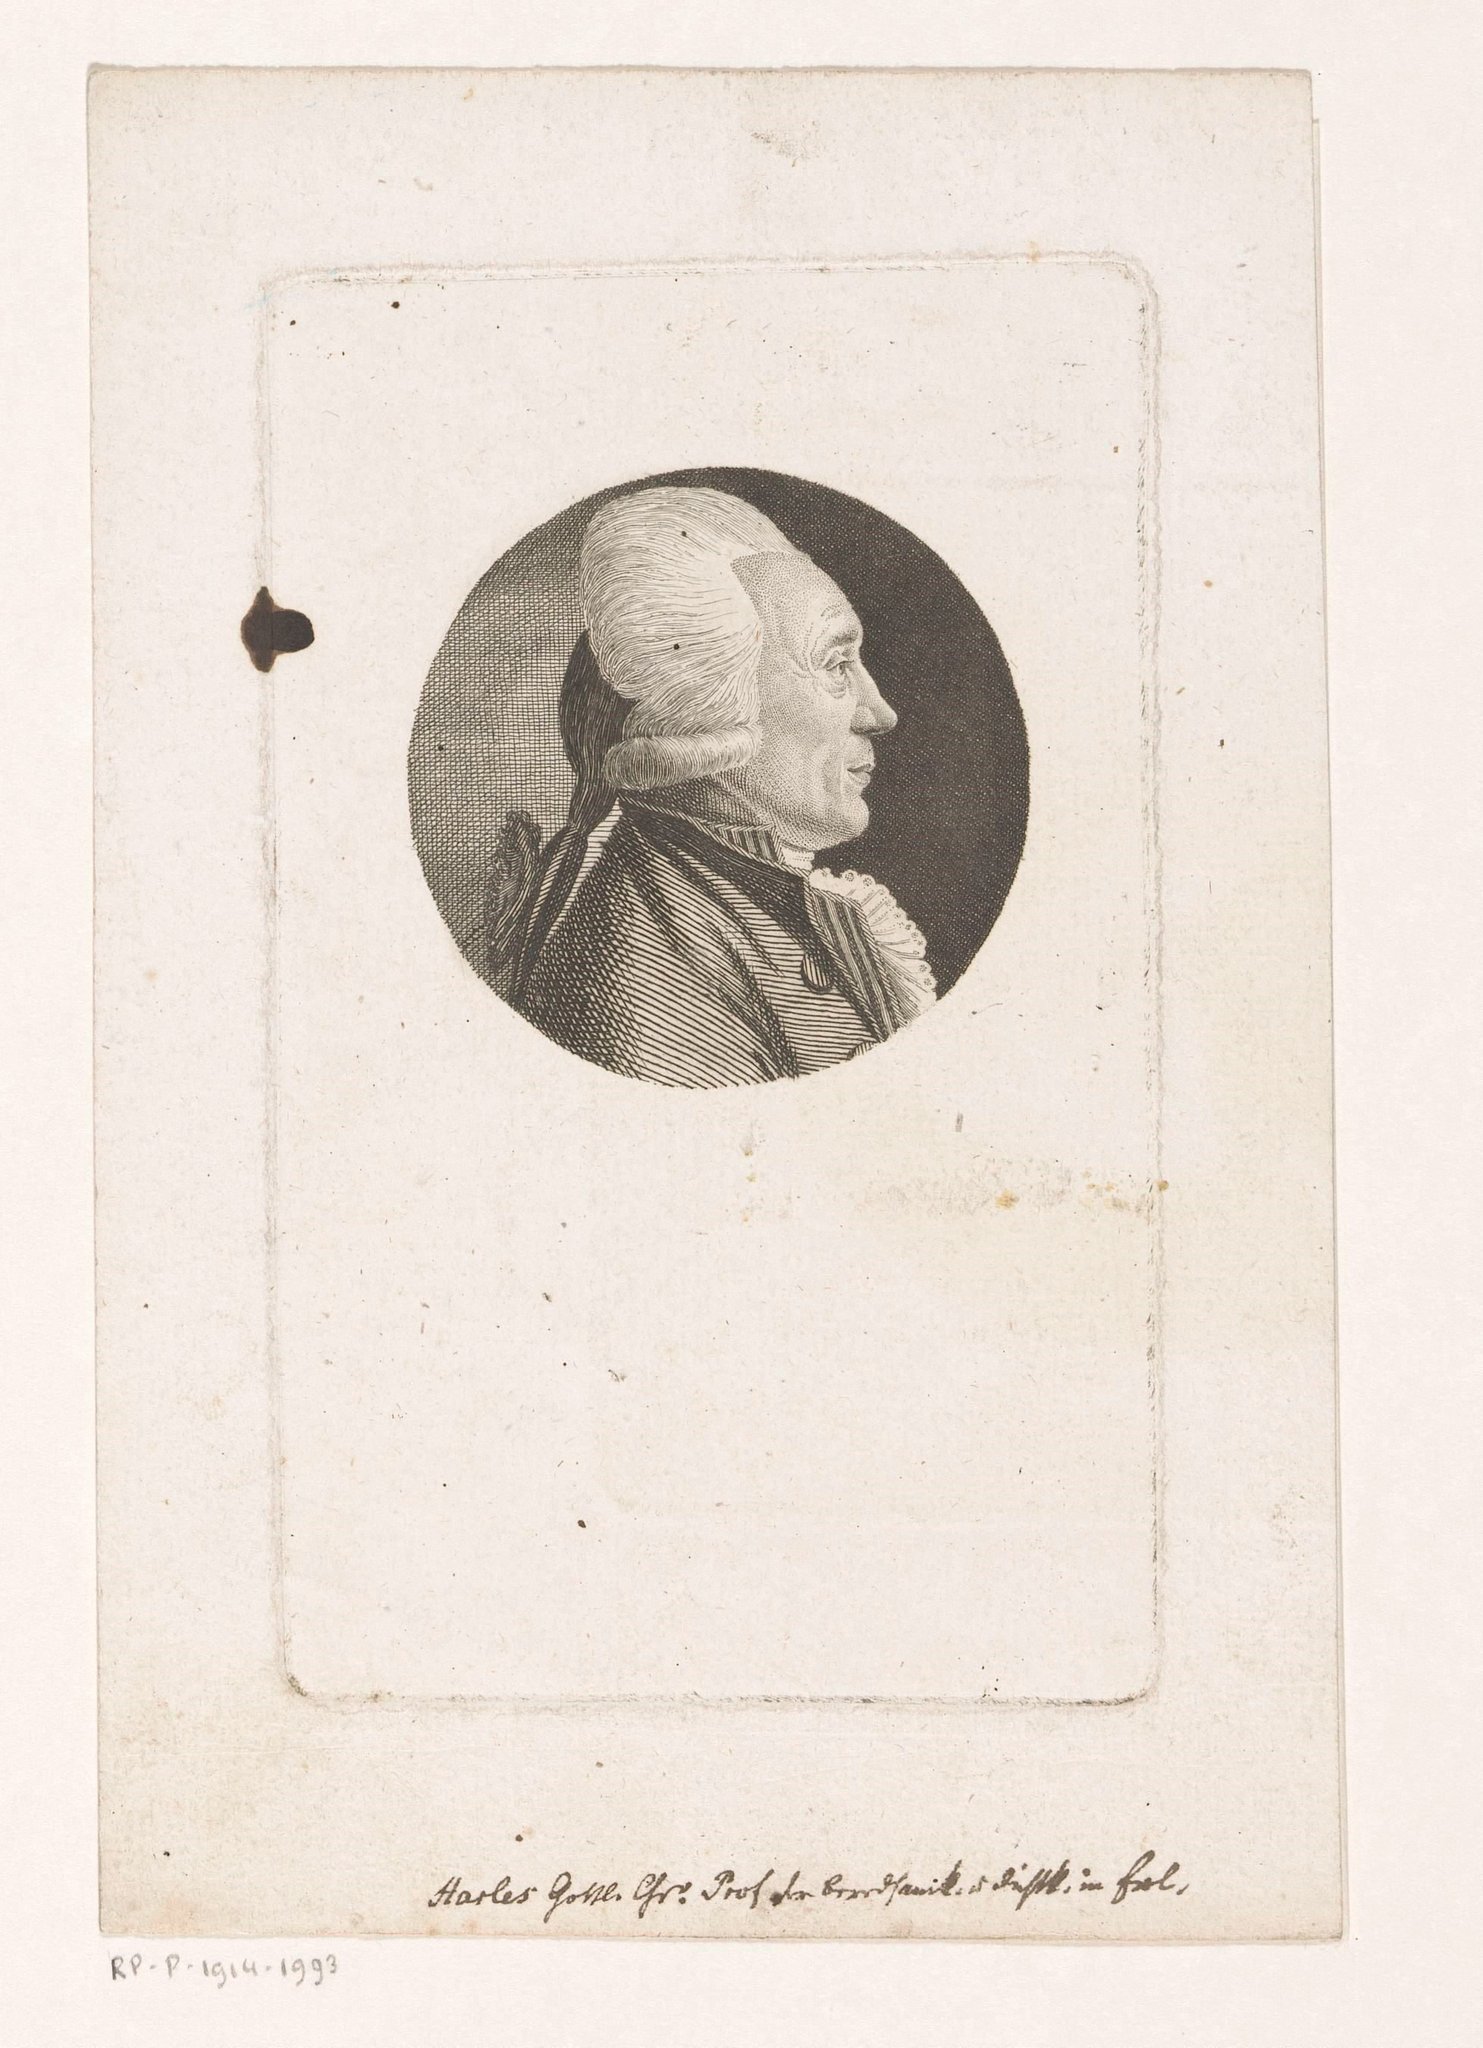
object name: print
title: Portret van Gottlieb Christoph Harless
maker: christoph wilhelm bock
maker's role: print maker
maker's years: 1755-1836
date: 1794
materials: paper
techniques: engraving, etching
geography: nuremberg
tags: historical persons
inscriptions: collector's mark: Lugt 2228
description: Op verso een fragment van het portret dat Christoph Wilhelm Bock in 1794 maakte van Christian Gottfried Junge.